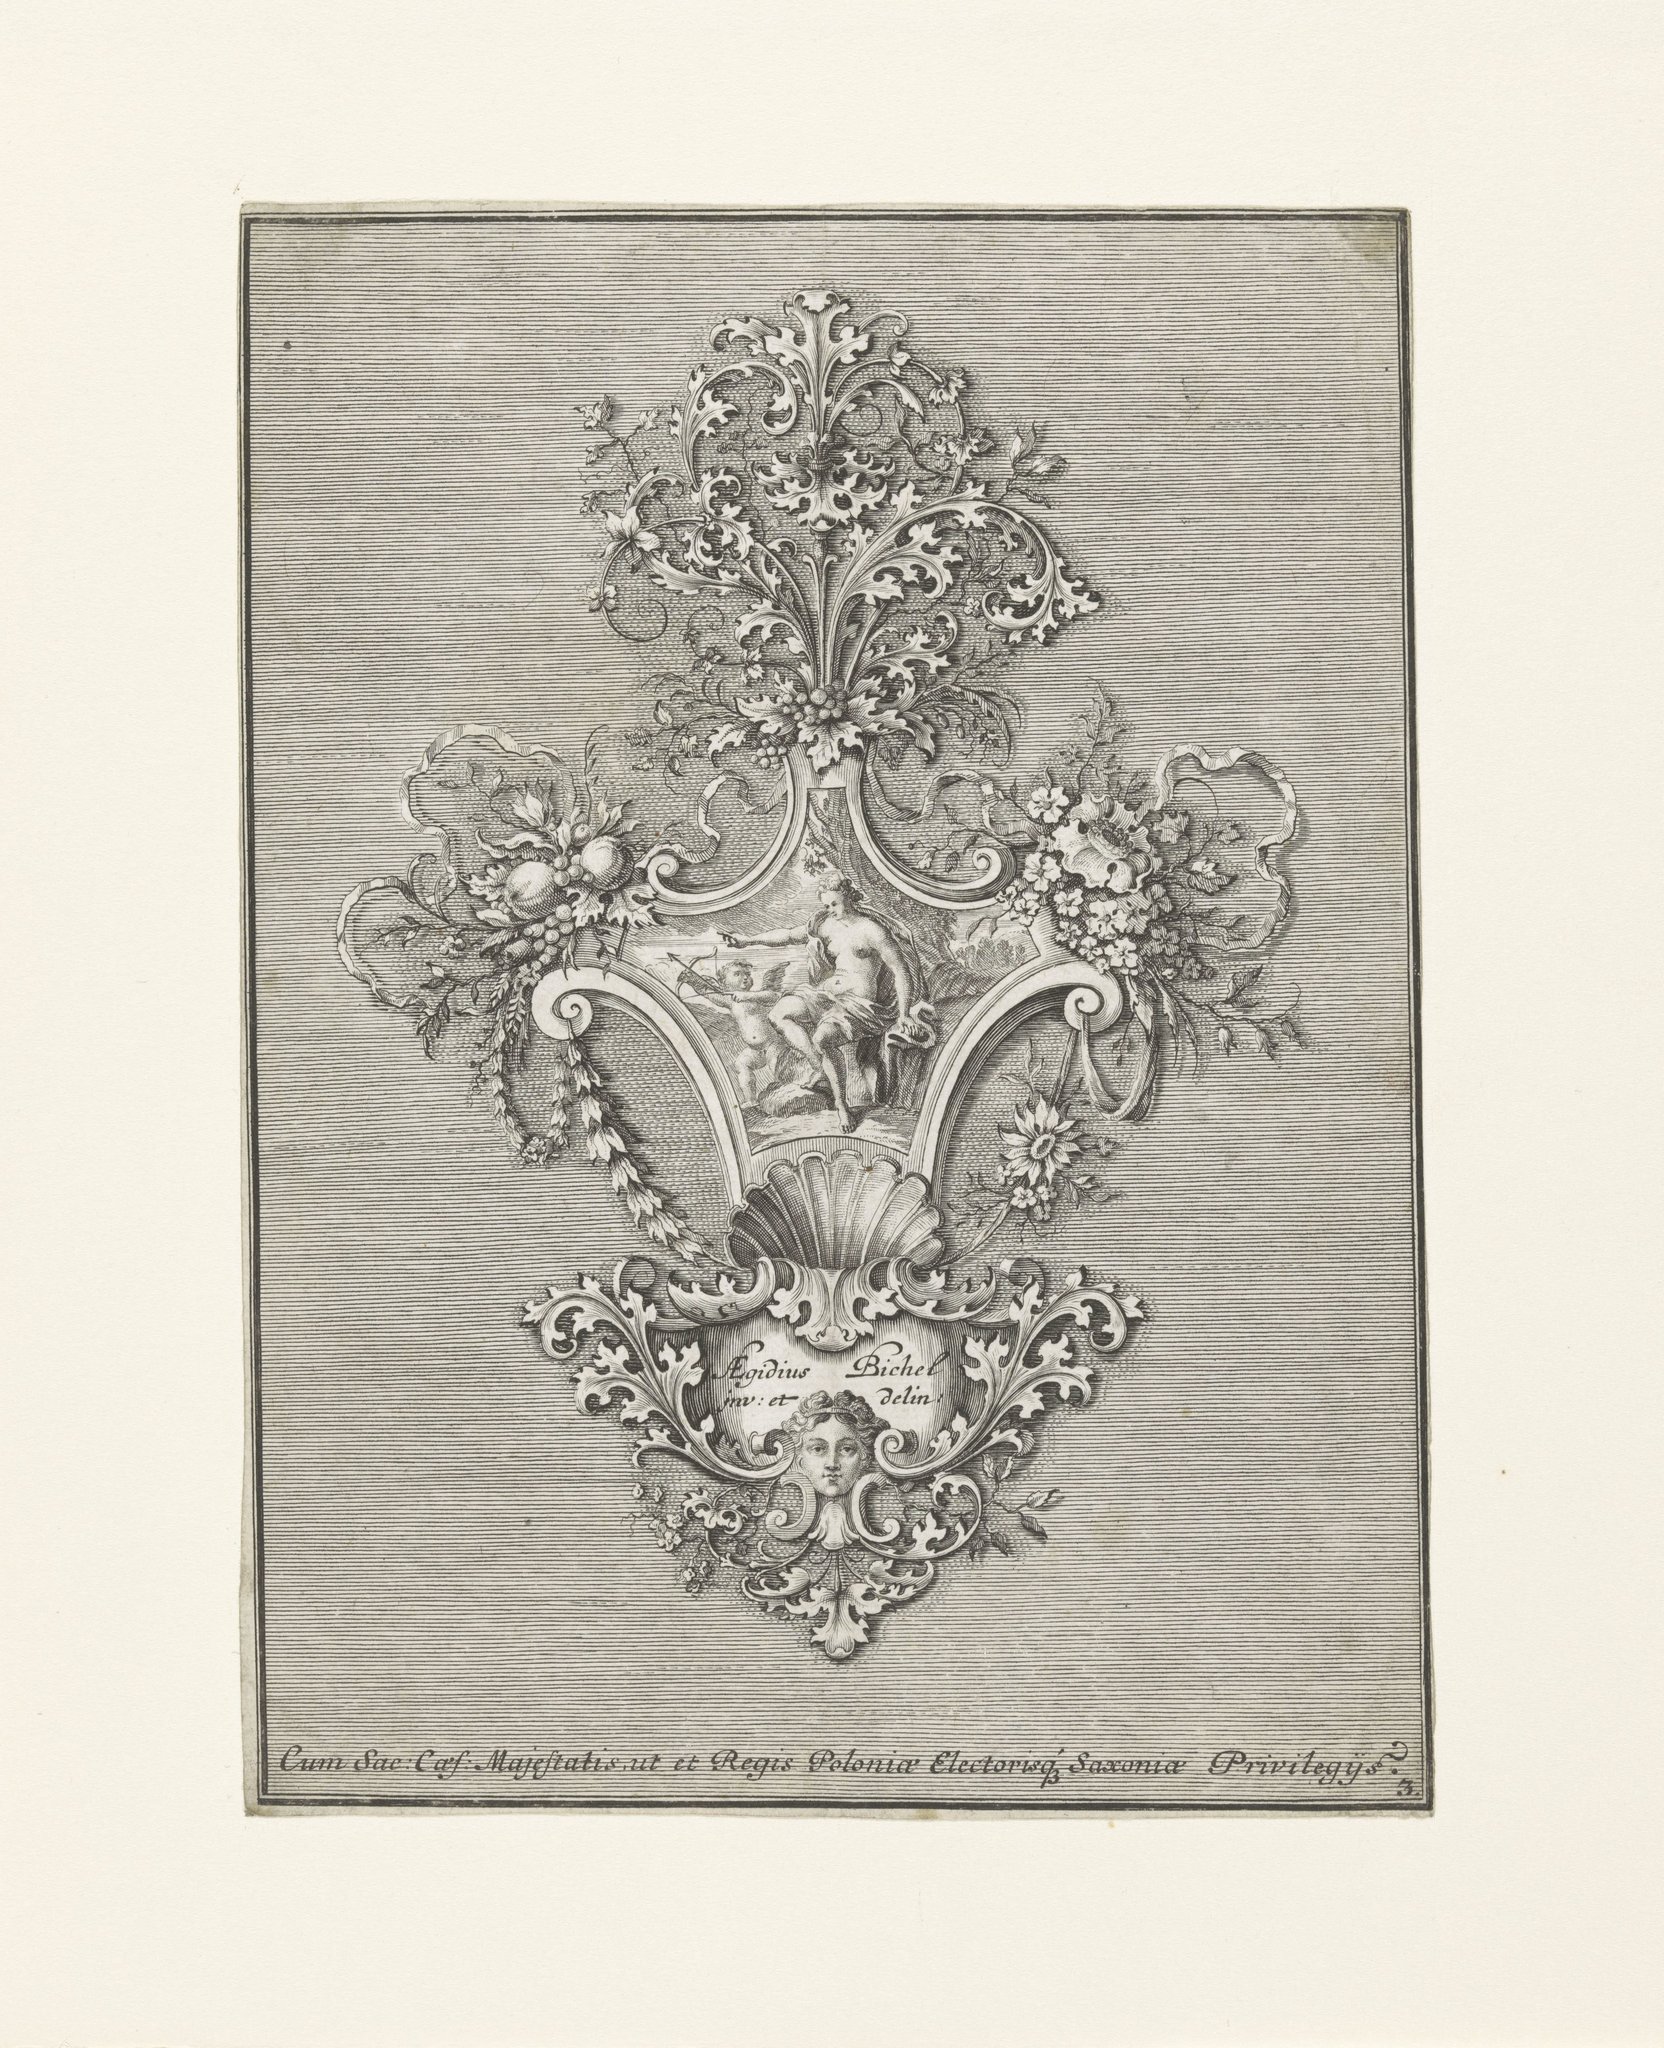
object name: ornament print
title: Wandbord met Venus en Amor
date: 1704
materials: paper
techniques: etching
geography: augsburg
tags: scallop, shell ~ ornament, (story of) venus (aphrodite), fruits, venus and cupid (cupid not being mere attribute)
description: In het midden stuurt Venus Amor met pijl-en-boog op pad. Het wandbord is versierd met vruchten en bloemen.